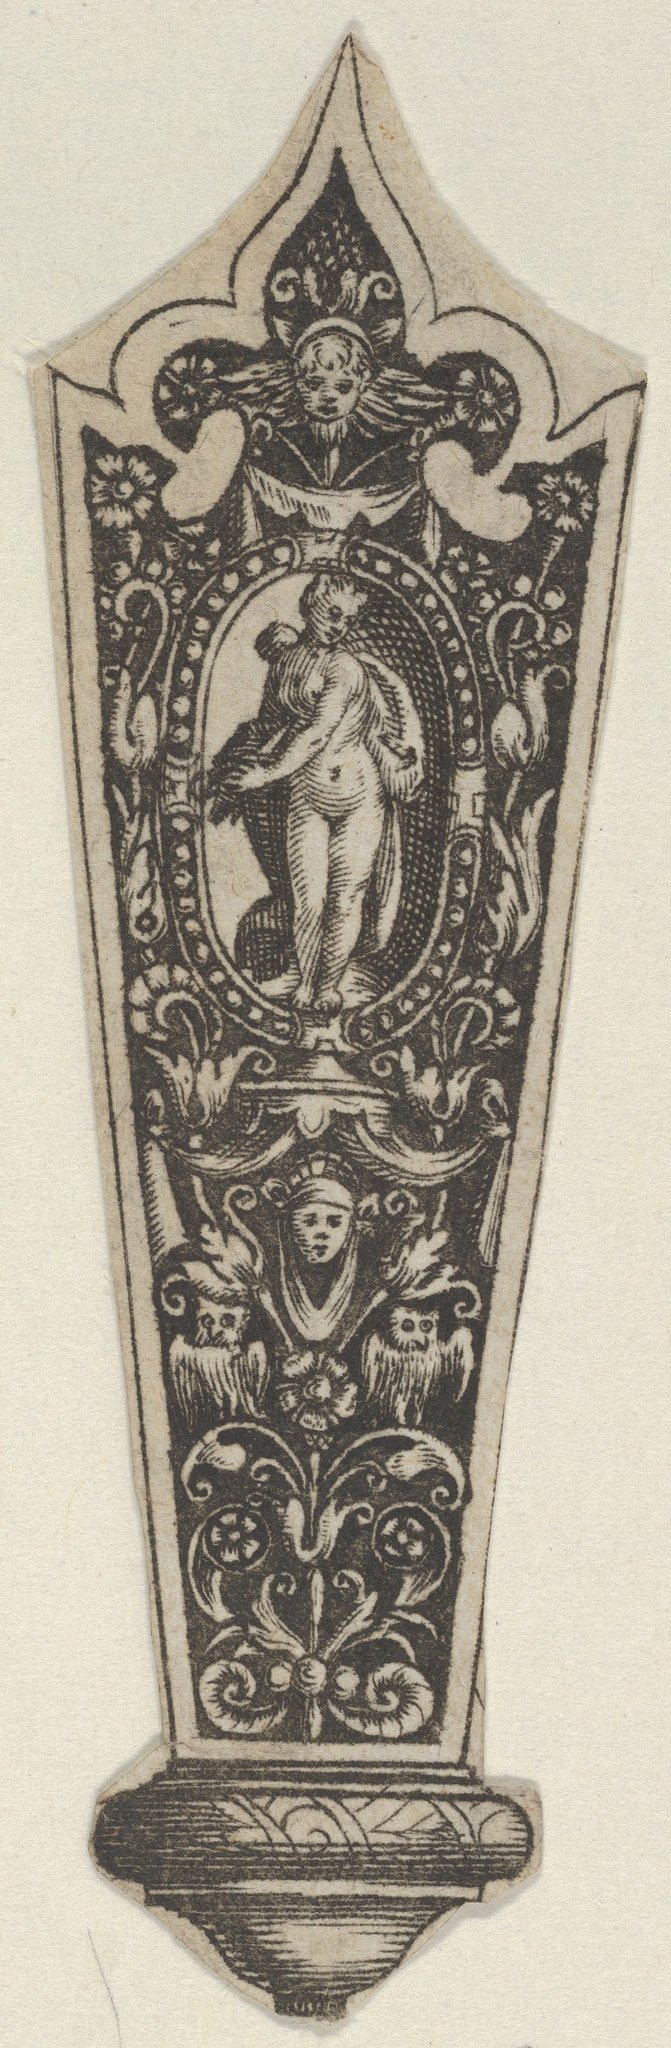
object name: print ornament architecture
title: Copy of a Design for a Knife Handle with the Death of Lucretia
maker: theodor de bry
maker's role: artist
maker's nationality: netherlandish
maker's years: 1528-1598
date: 1580-1600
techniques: embroidery, engraving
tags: faces,female nudes,owls